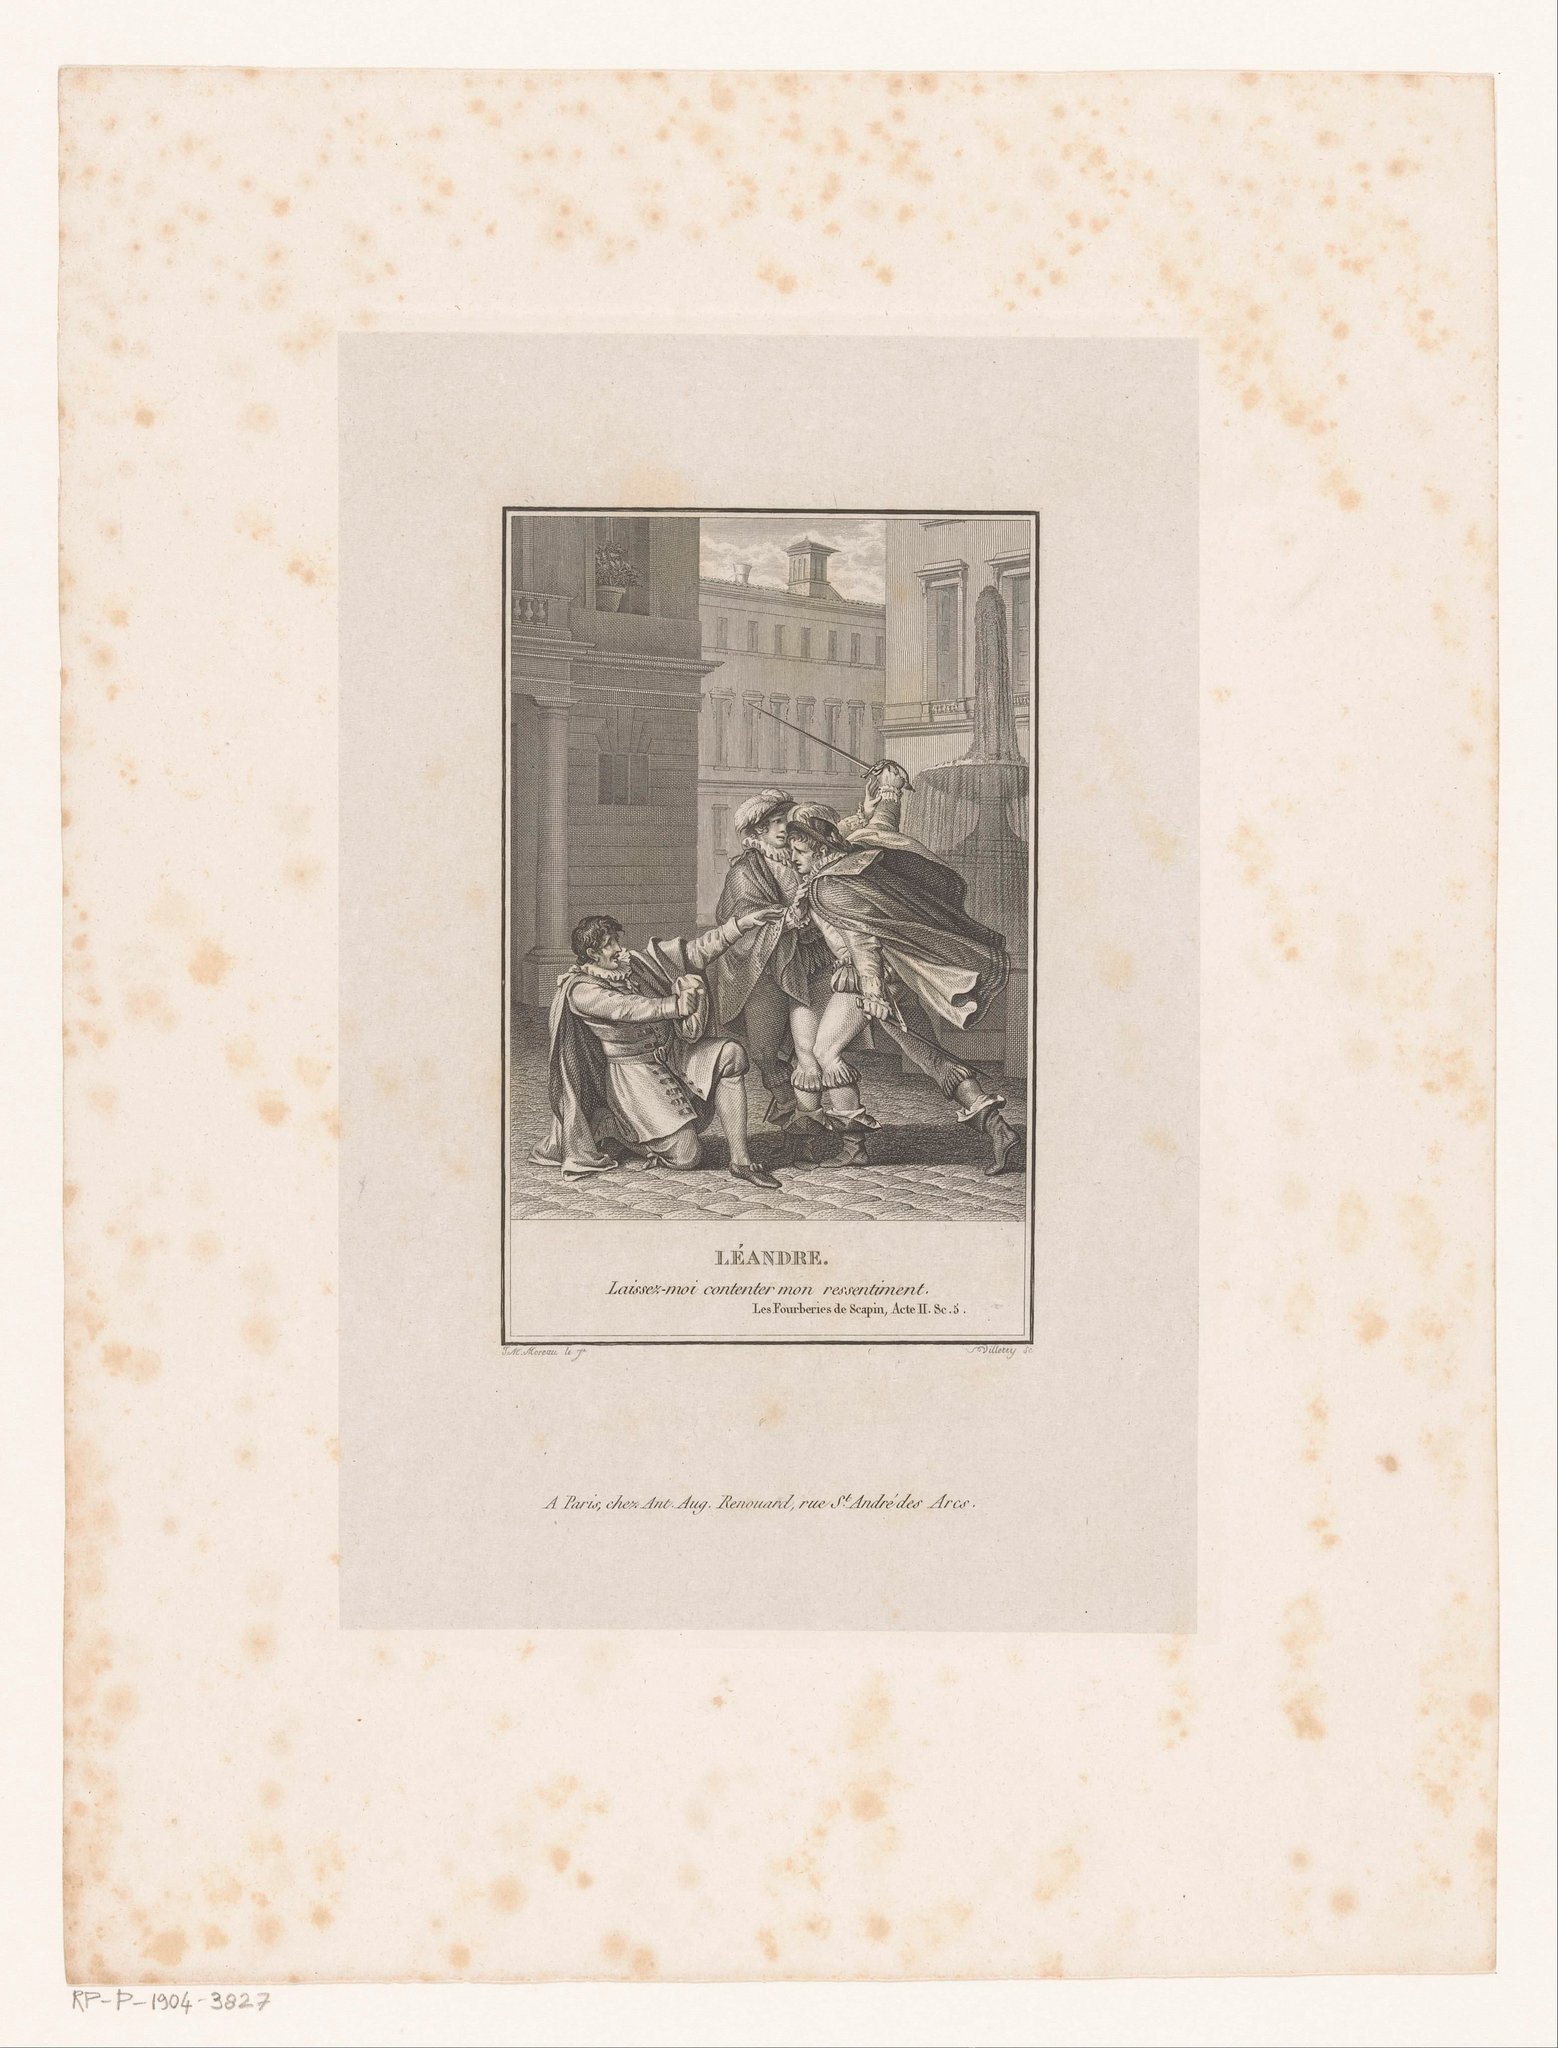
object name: book illustration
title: Léandre valt zijn bediende Scapin aan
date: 1811-1813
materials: paper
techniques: engraving, etching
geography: france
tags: theatre, theatrical performance, ornamental fountain (in village), fighting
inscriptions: collector's mark: Lugt 2228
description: Prent van scène vijf van de tweede acte uit 'Les Fourberies de Scapin' door Jean Baptiste Molière. Dit betreft een van de dertig prenten, gemaakt in opdracht van Antoine Augustin Renouard, bestemd voor verschillende edities van Molières werk daterend van 1811 tot 1813. De prenten zijn vervaardigd door verschillende kunstenaars naar composities van Moreau.